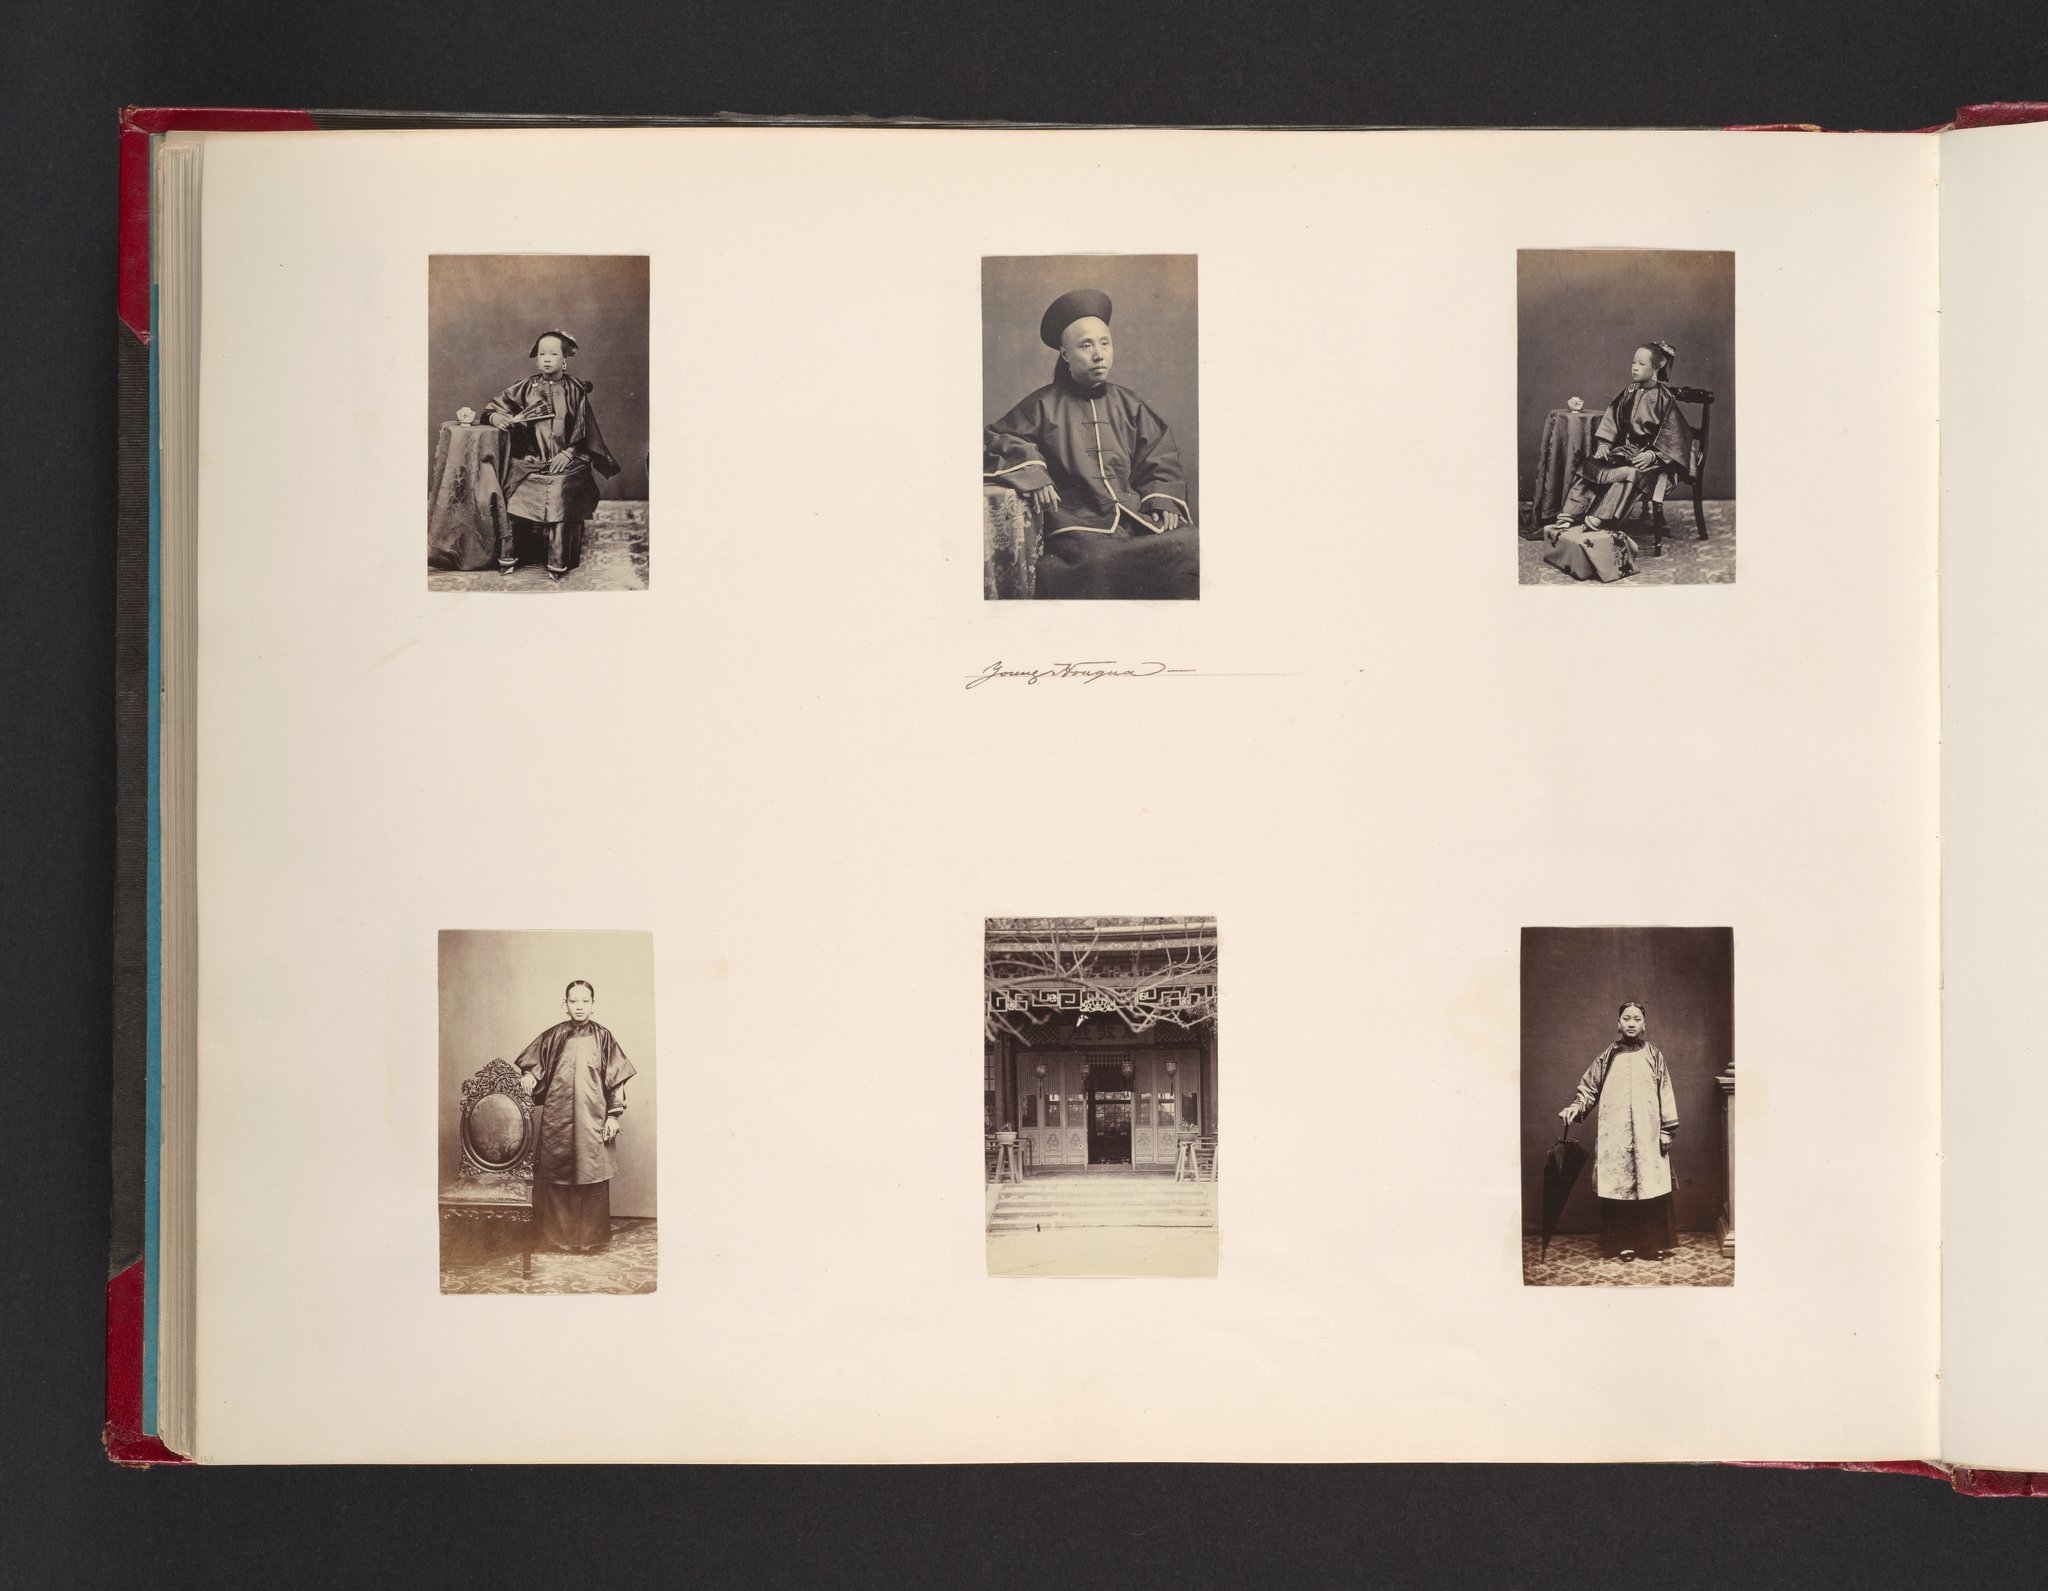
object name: photograph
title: Young Houqa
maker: john thomson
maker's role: artist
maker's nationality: british, scottish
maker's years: 1837-1921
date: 1865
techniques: albumen silver print, glass negative